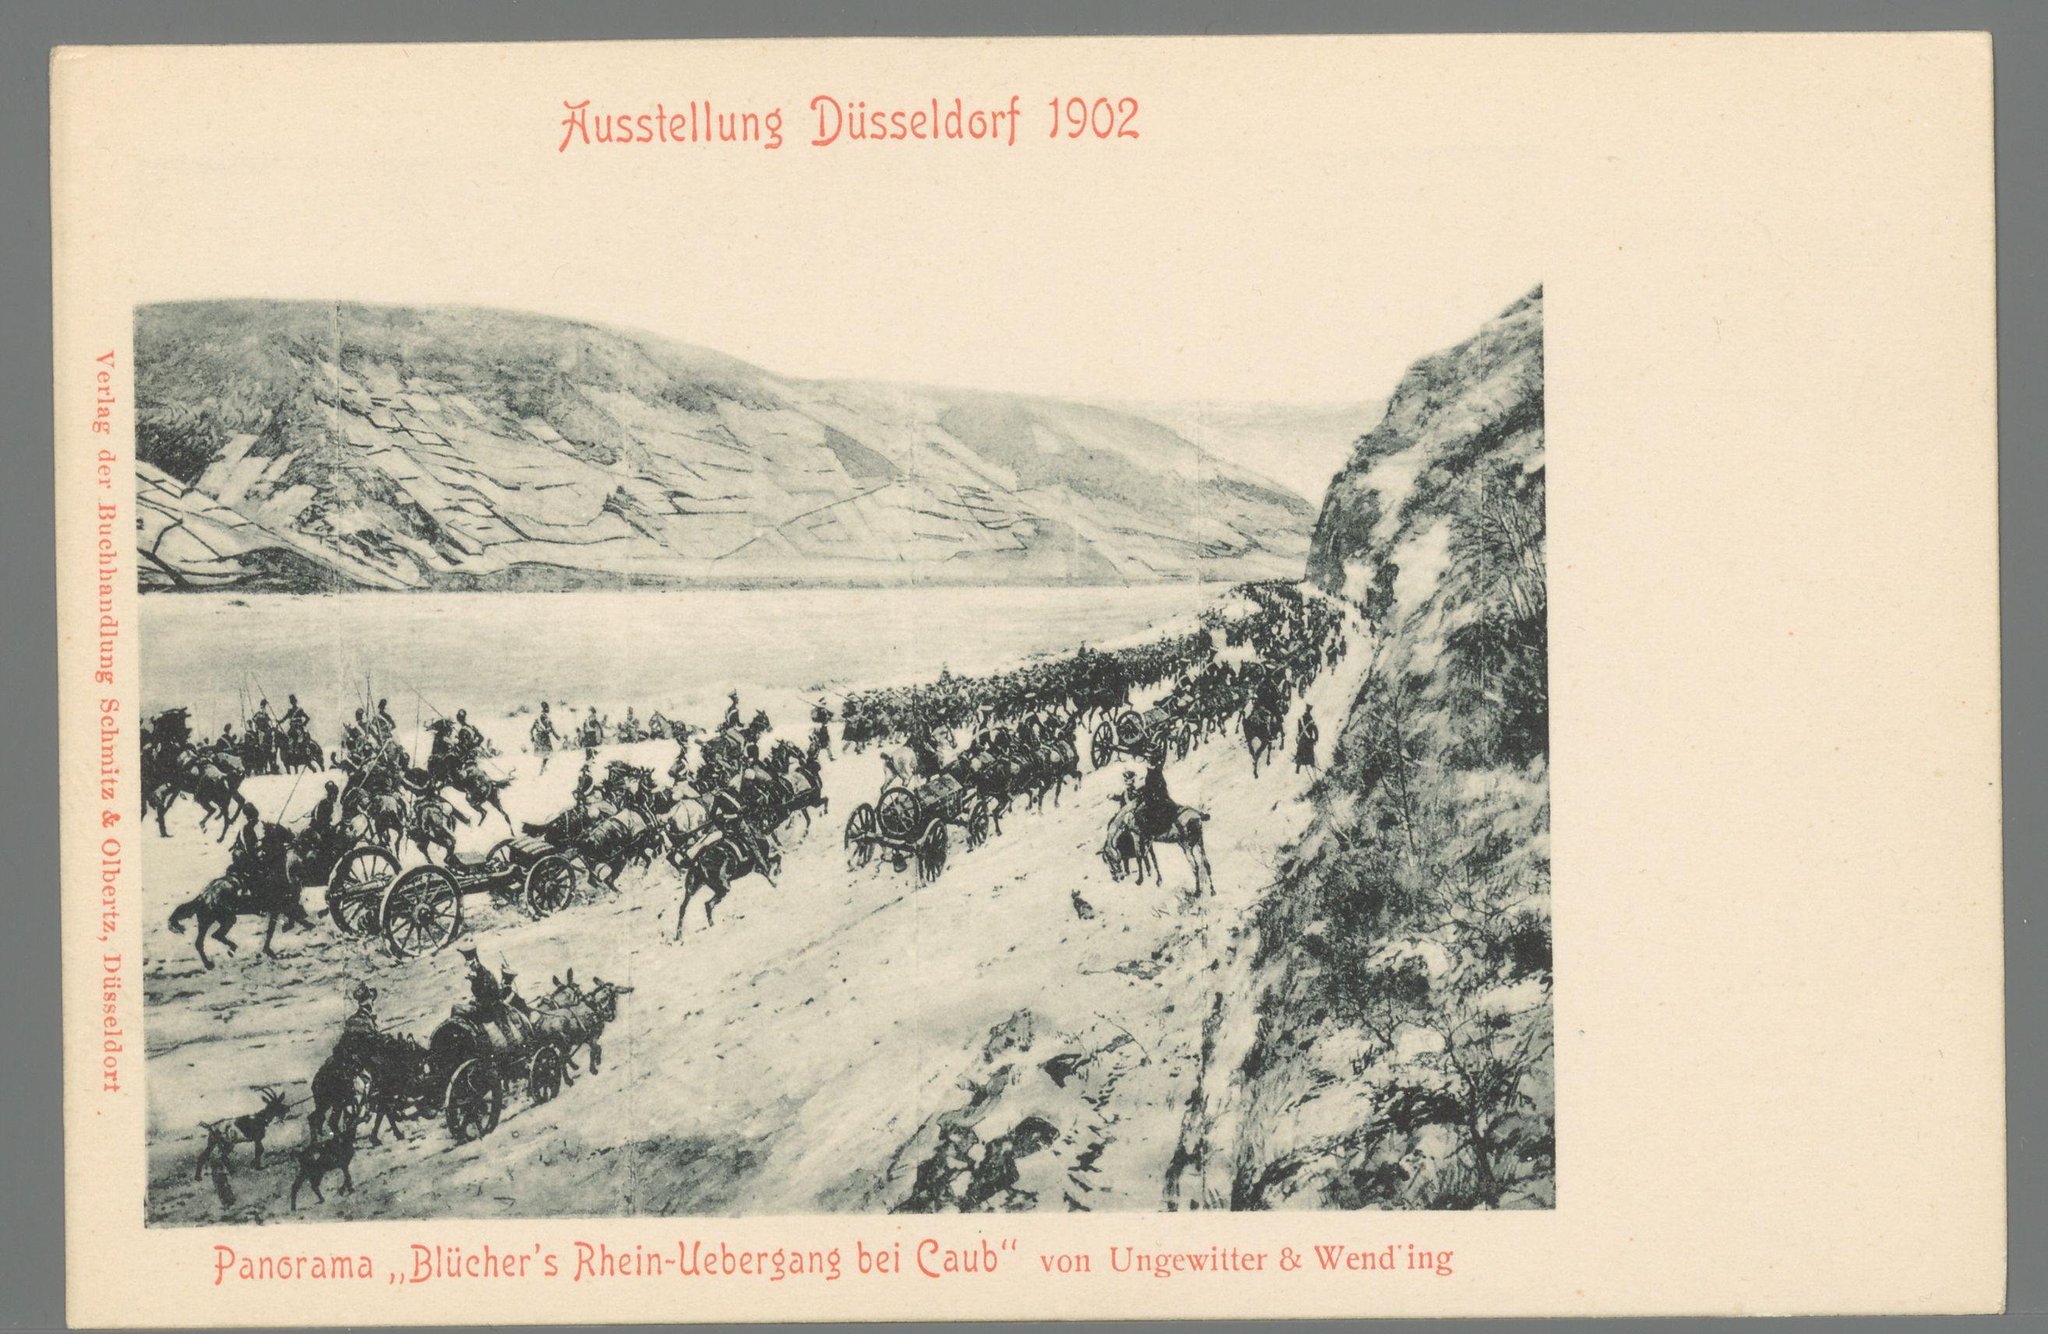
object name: photomechanical print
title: Ausstellung Düsseldorf 1902. Panorama "Blücher's Rhein-Uebergang bei Caub" von Ungewitter & Wending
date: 1902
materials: cardboard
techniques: photograph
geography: dusseldorf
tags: army 'en route', canals, waters (in city), temporary exhibition, 'salon'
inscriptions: date